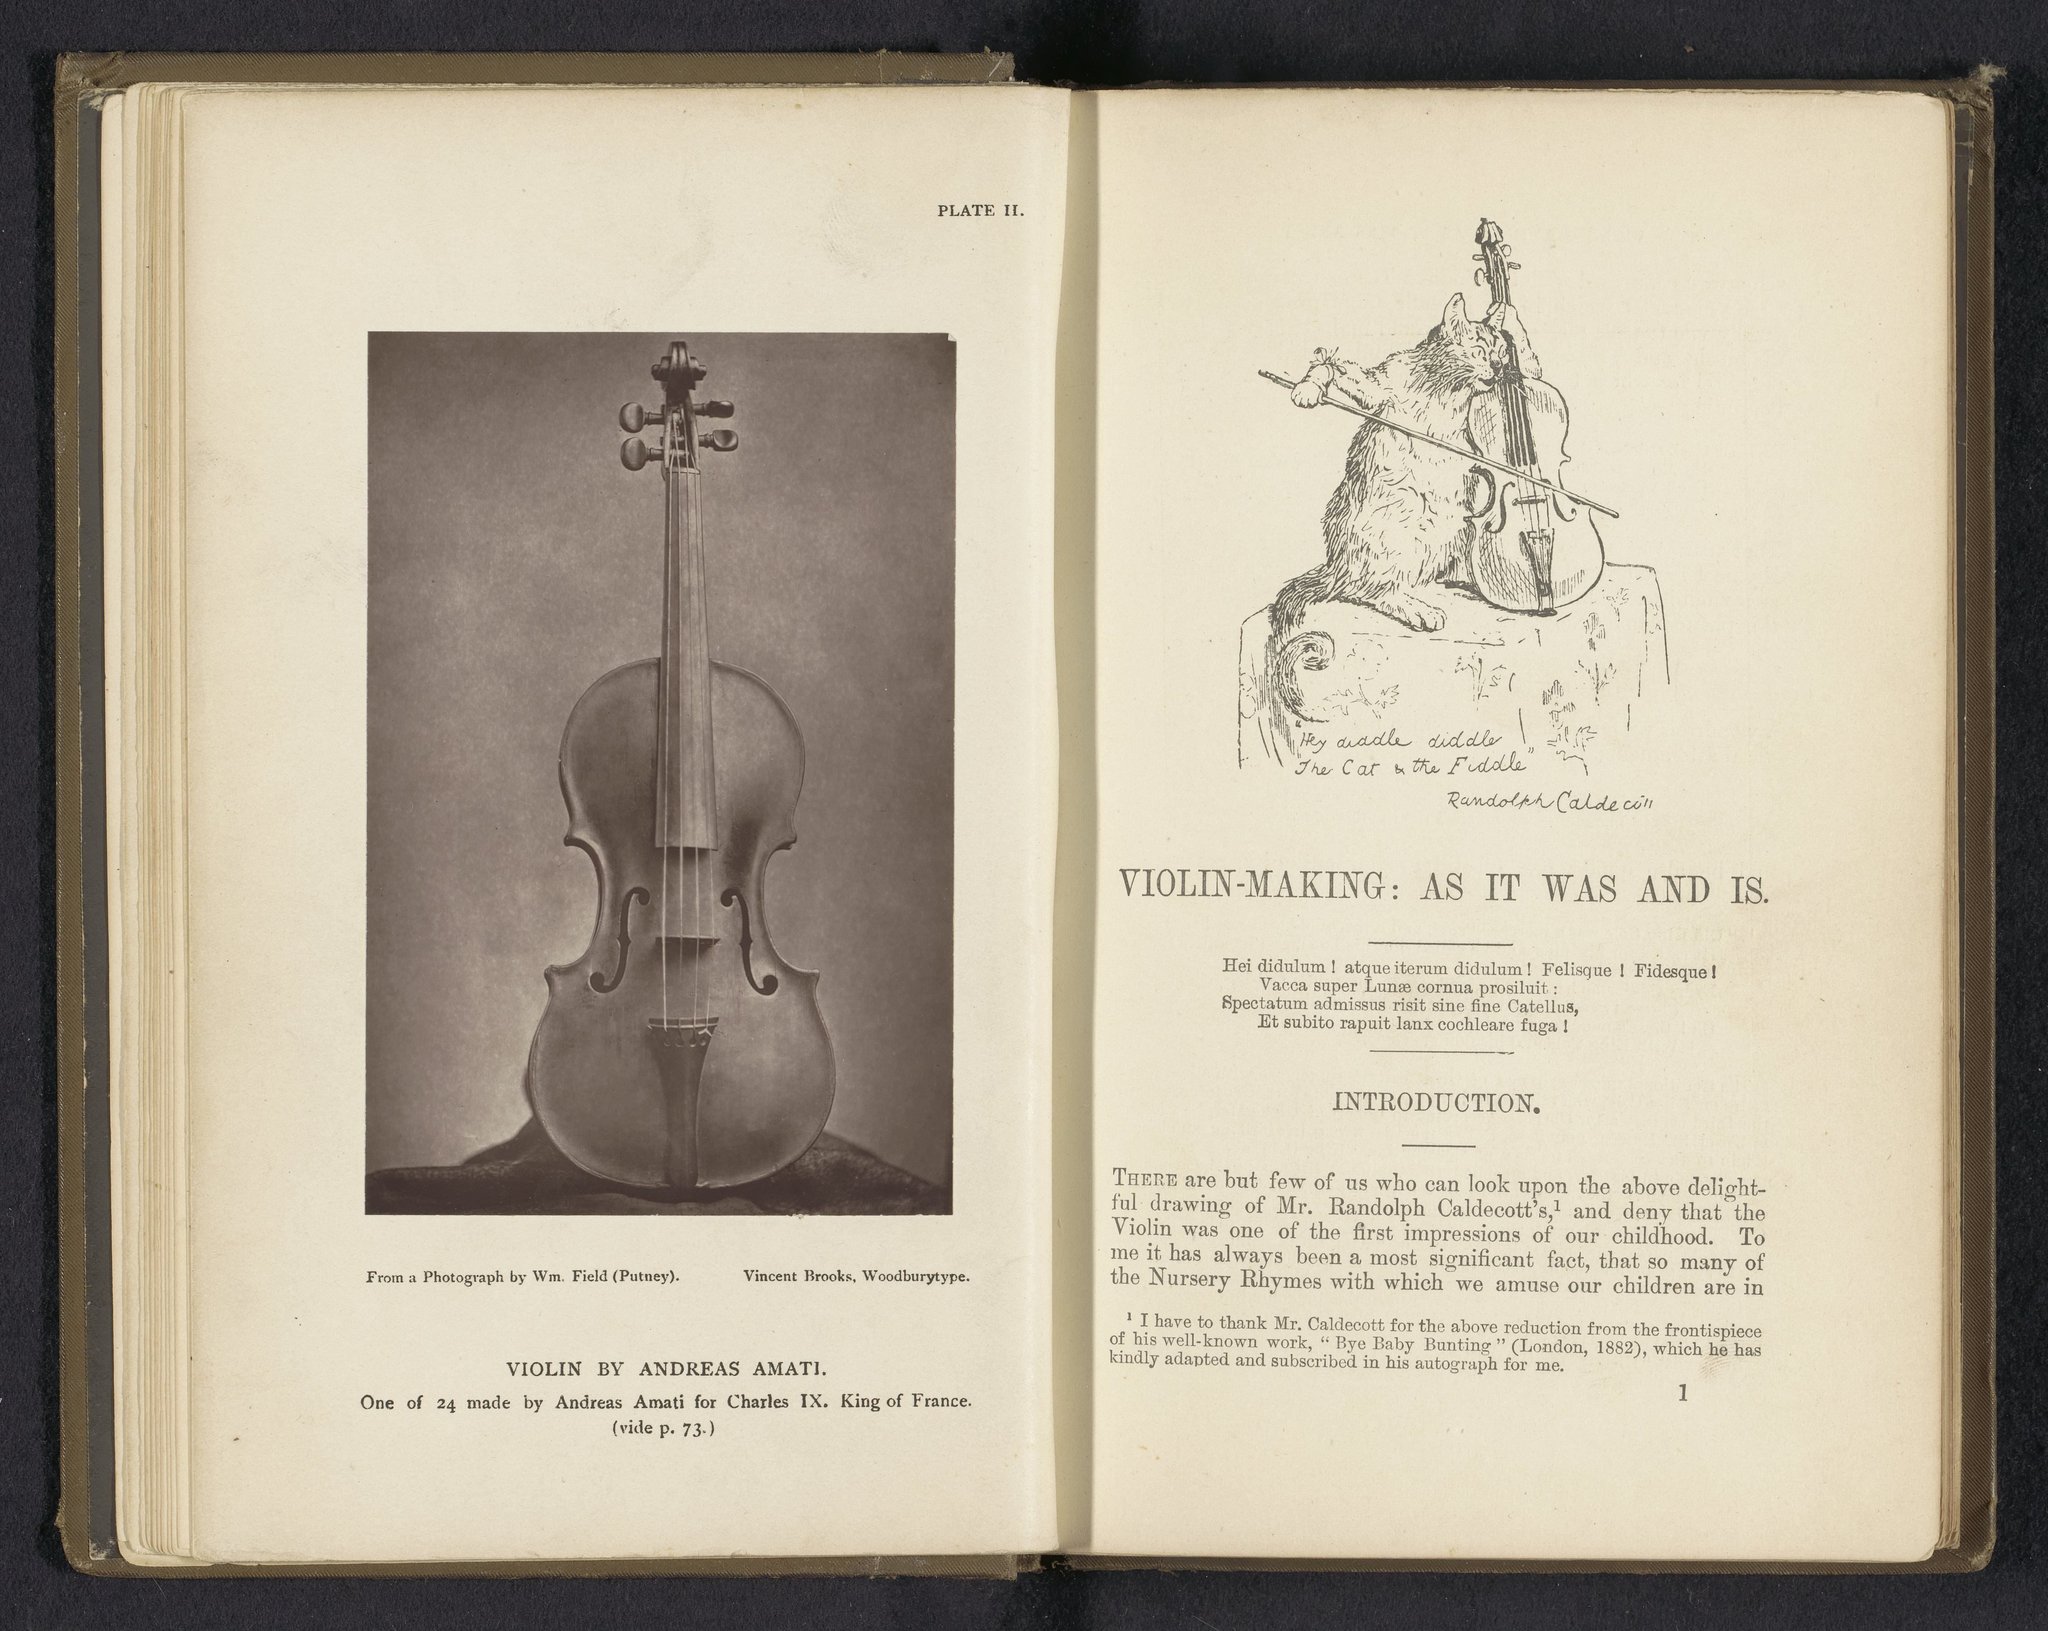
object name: page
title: Violin by Andreas Amati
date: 1875-1885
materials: paper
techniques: woodburytype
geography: great britain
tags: violin, fiddle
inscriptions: inscription: ‘One of 24 made by Andreas Amati for Charles IX. King of France.’, number: ‘Plate II.’